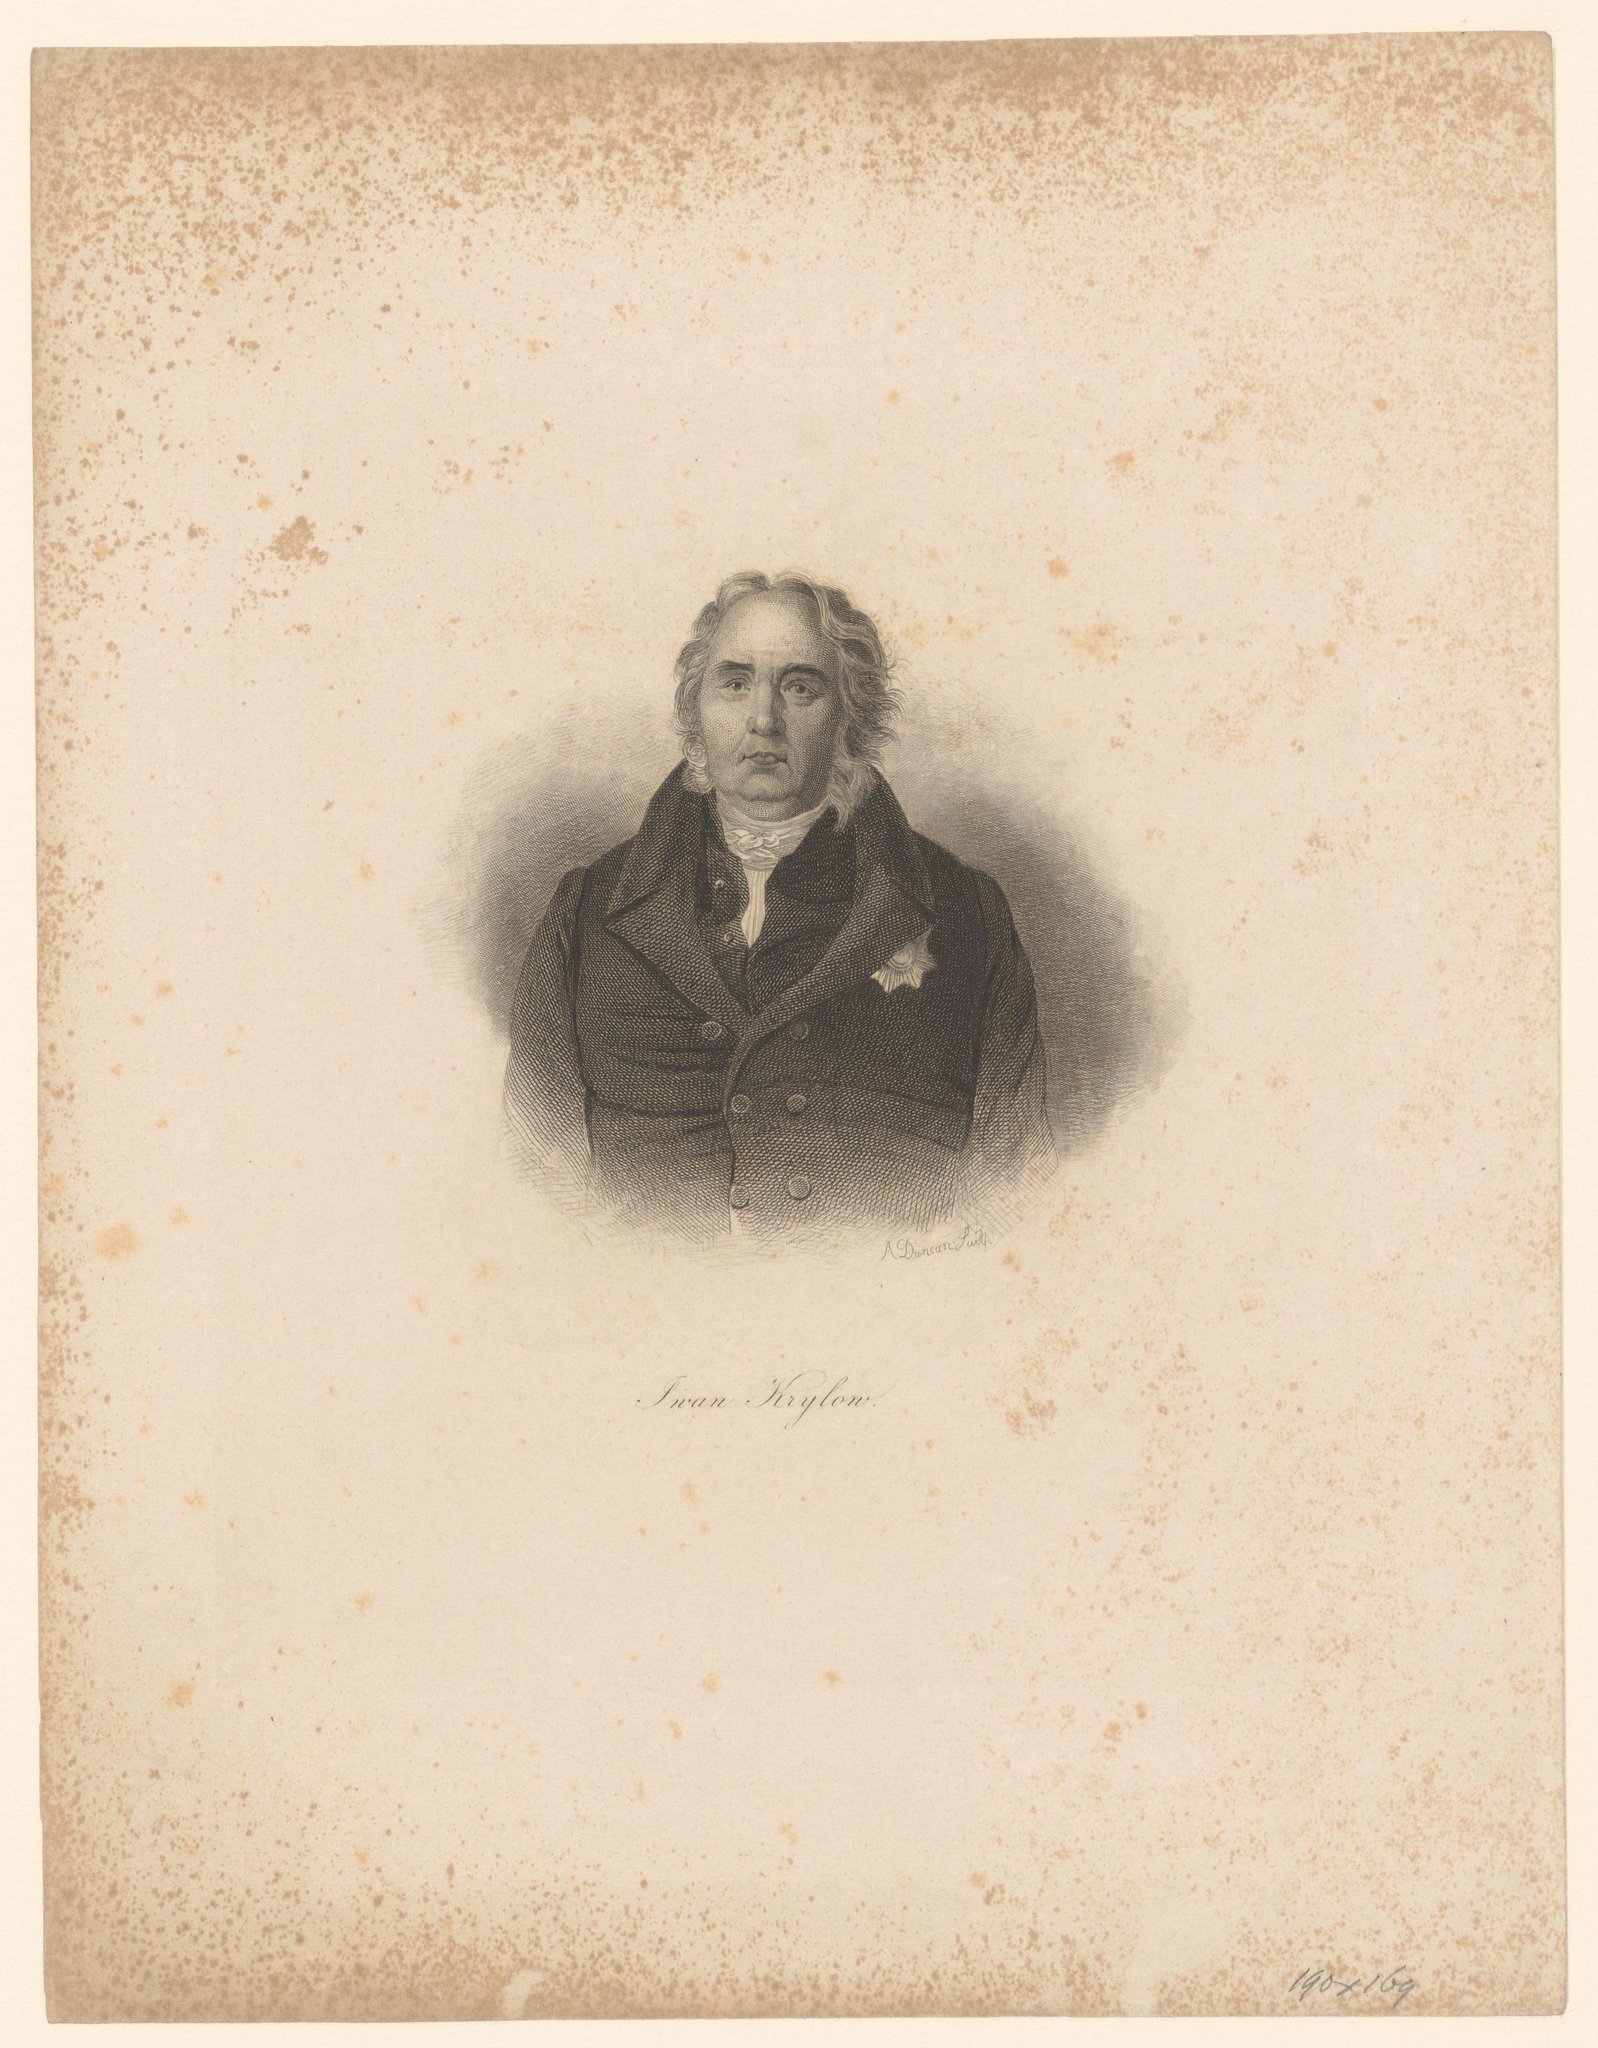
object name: print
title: Portret van Iwan Andrejewitsch Krylow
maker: andrew duncan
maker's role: print maker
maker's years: 1795-1855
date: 1805-1895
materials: paper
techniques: engraving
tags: historical persons, writer, poet, author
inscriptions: collector's mark: Lugt 2228